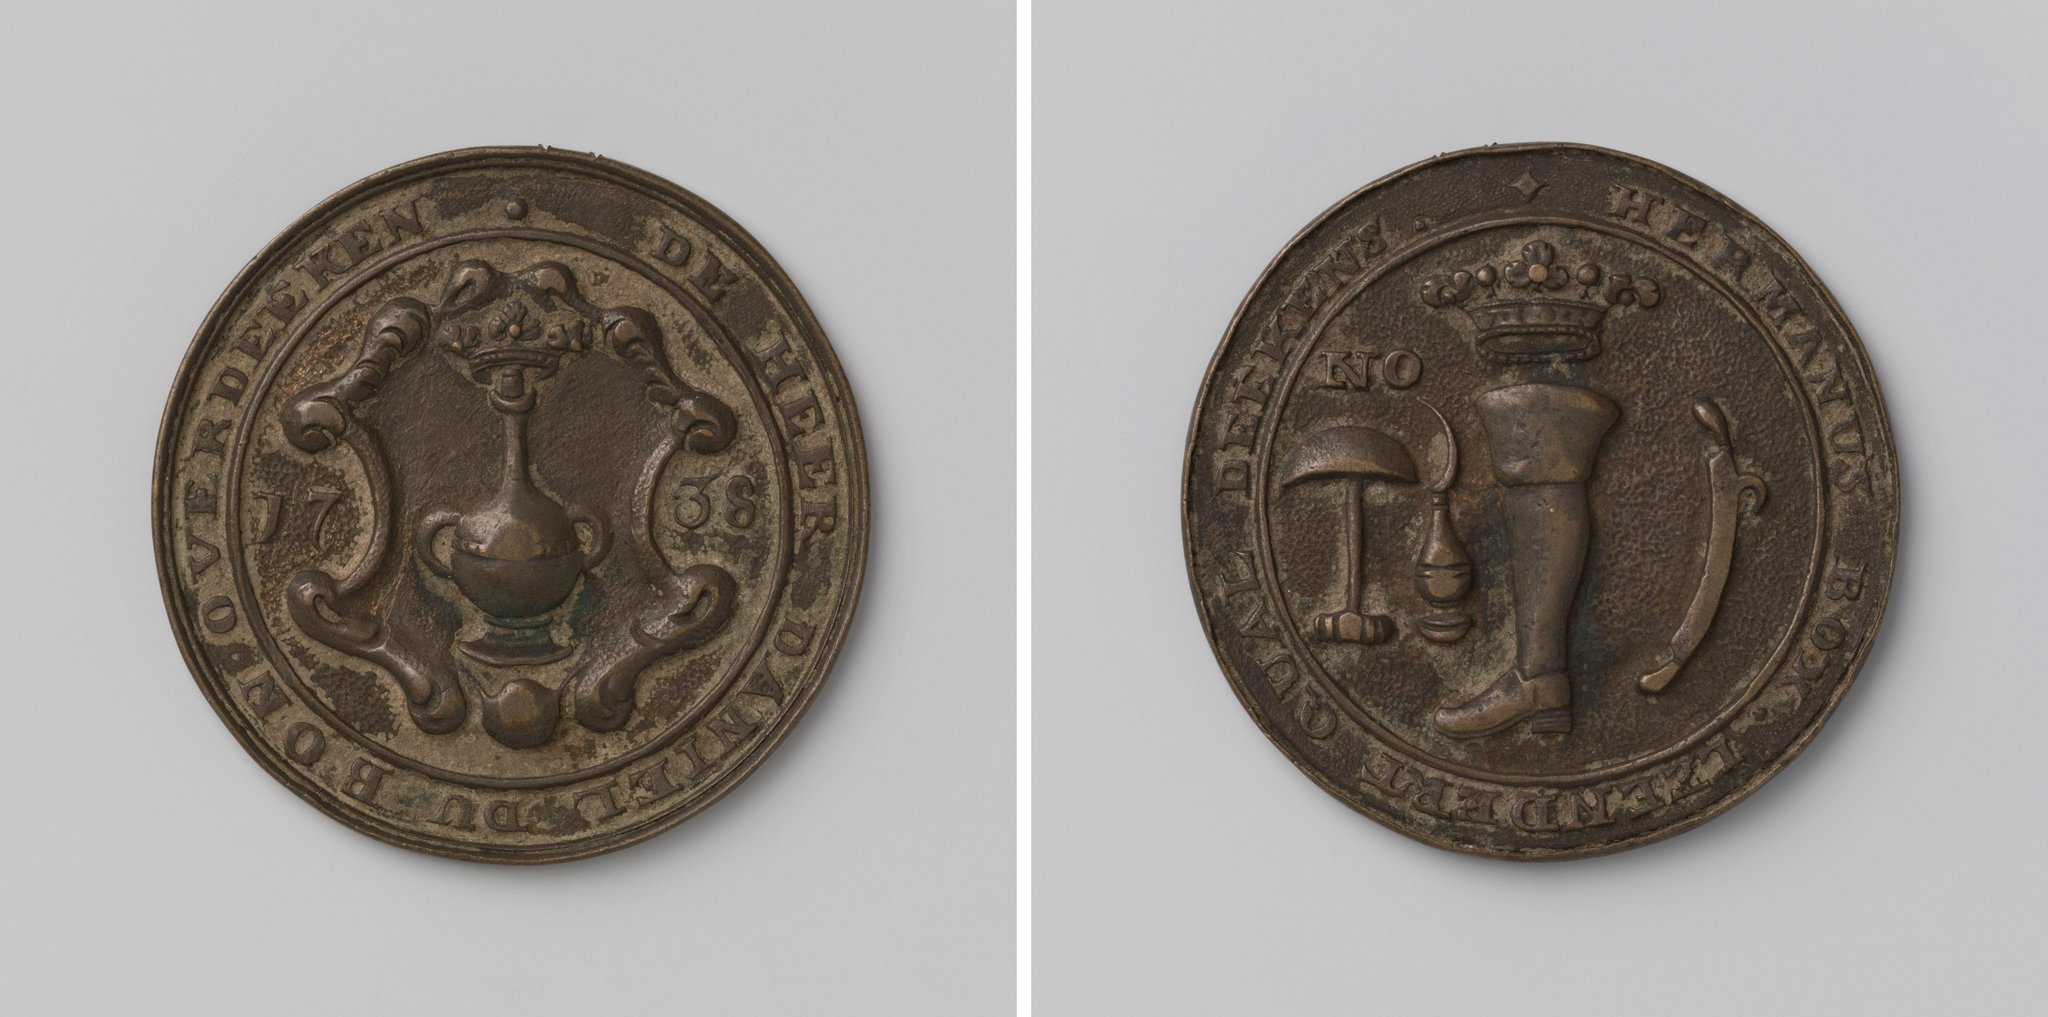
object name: medal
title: Schoenmakersgilde van Vlissingen, gildepenning met no. 2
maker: Anonymous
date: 1738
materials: brass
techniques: casting, engraving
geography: flushing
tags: flushing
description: Messing penning. Voorzijde: gekroonde fles in cartouche tussen jaartal binnen omschrift. Keerzijde: schoenmakersmes, els, gekroonde kaplaars en looiersmes onder opschrift; randschrift: II